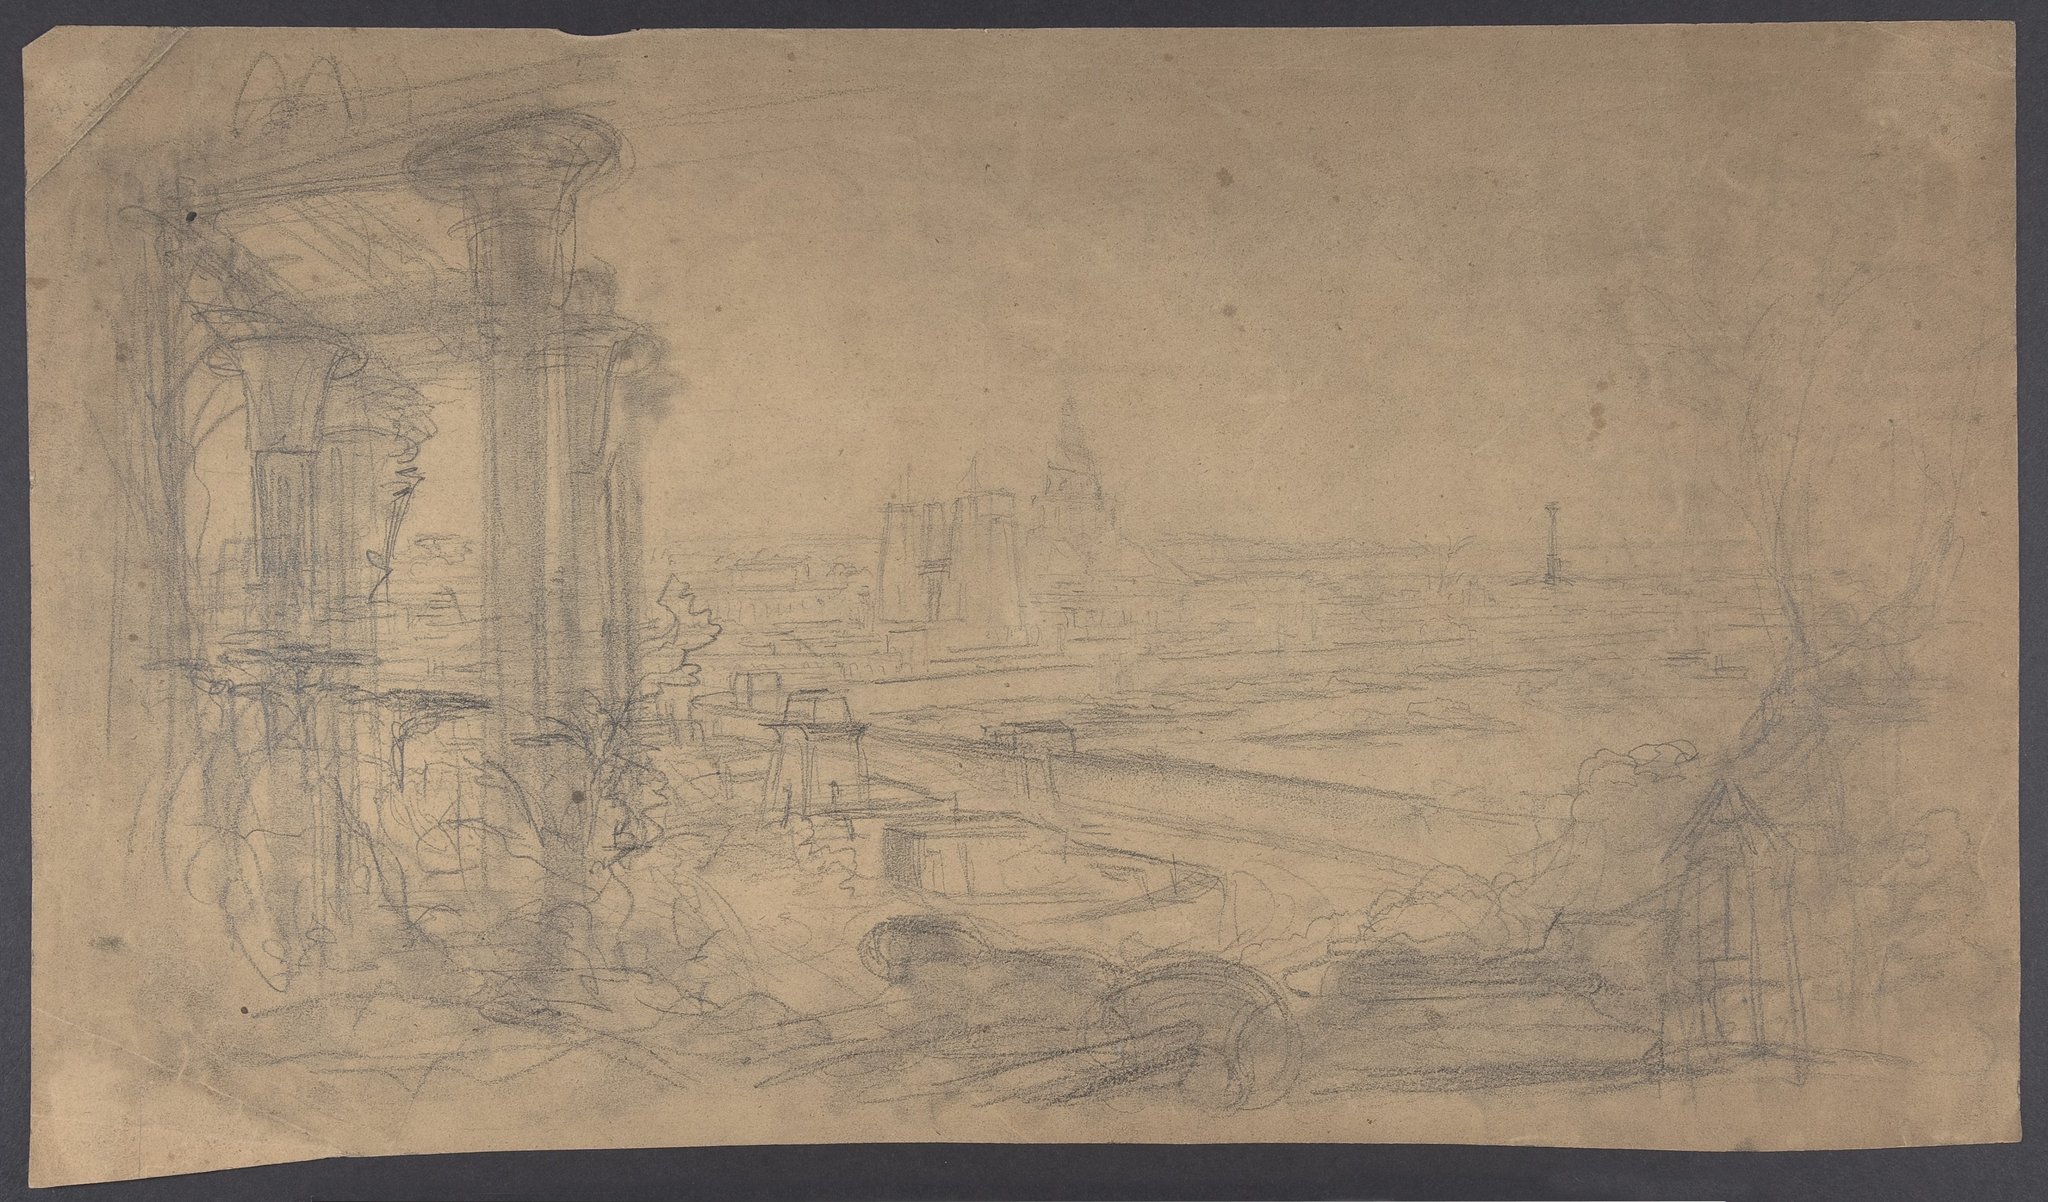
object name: drawing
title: Design for a Stage Set at the Opéra, Paris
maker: eugène cicéri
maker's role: artist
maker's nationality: french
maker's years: 1813-1890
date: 1830-1890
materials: graphite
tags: stage design